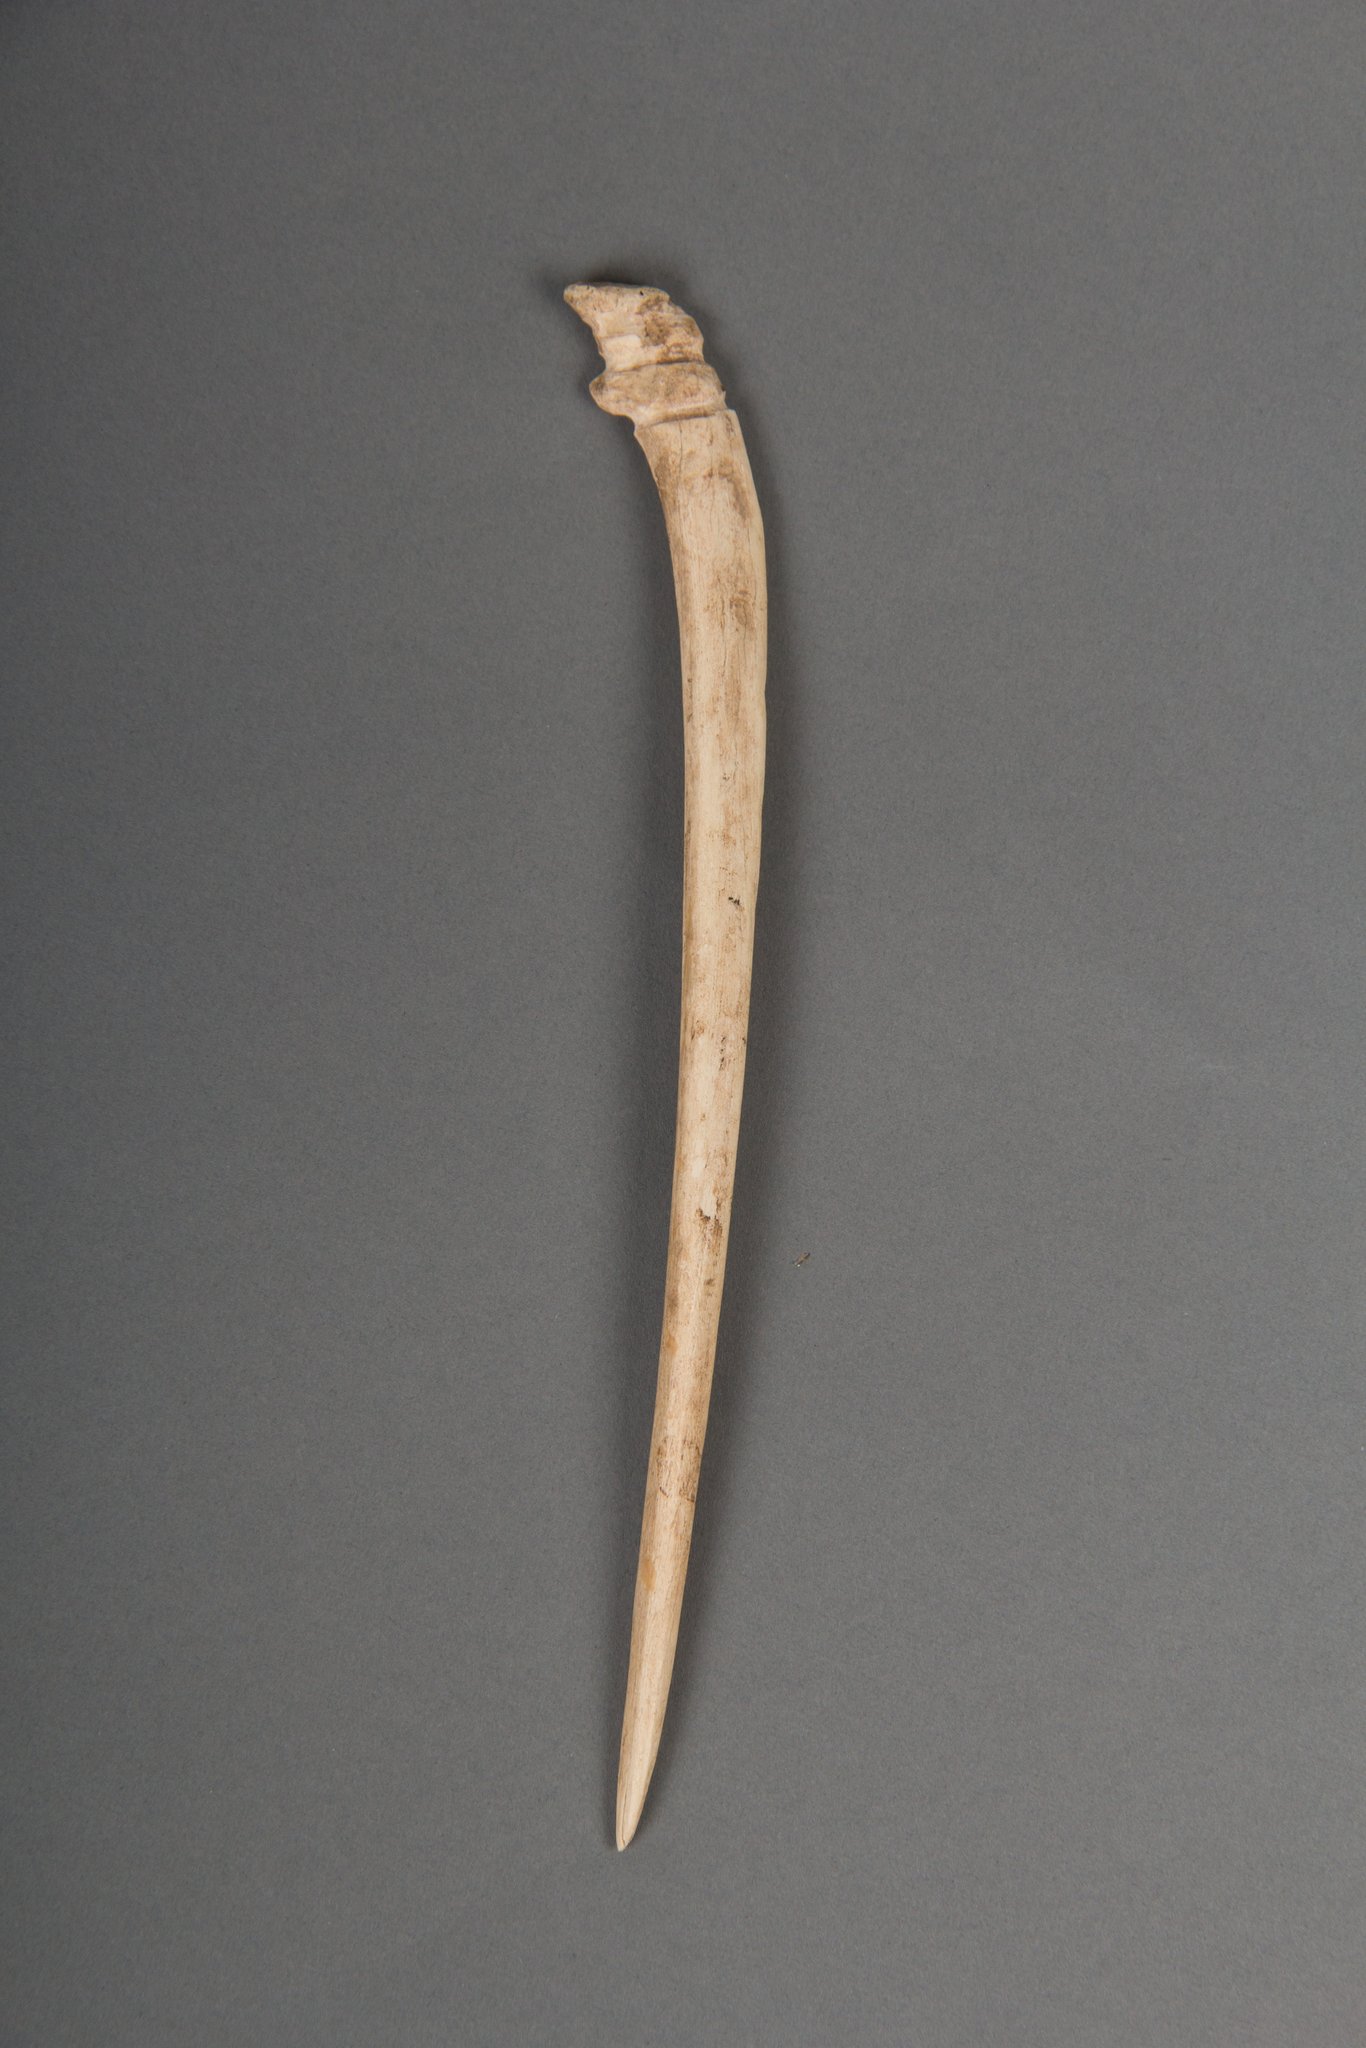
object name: hairpin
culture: japanese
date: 1200-200 BCE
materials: bone